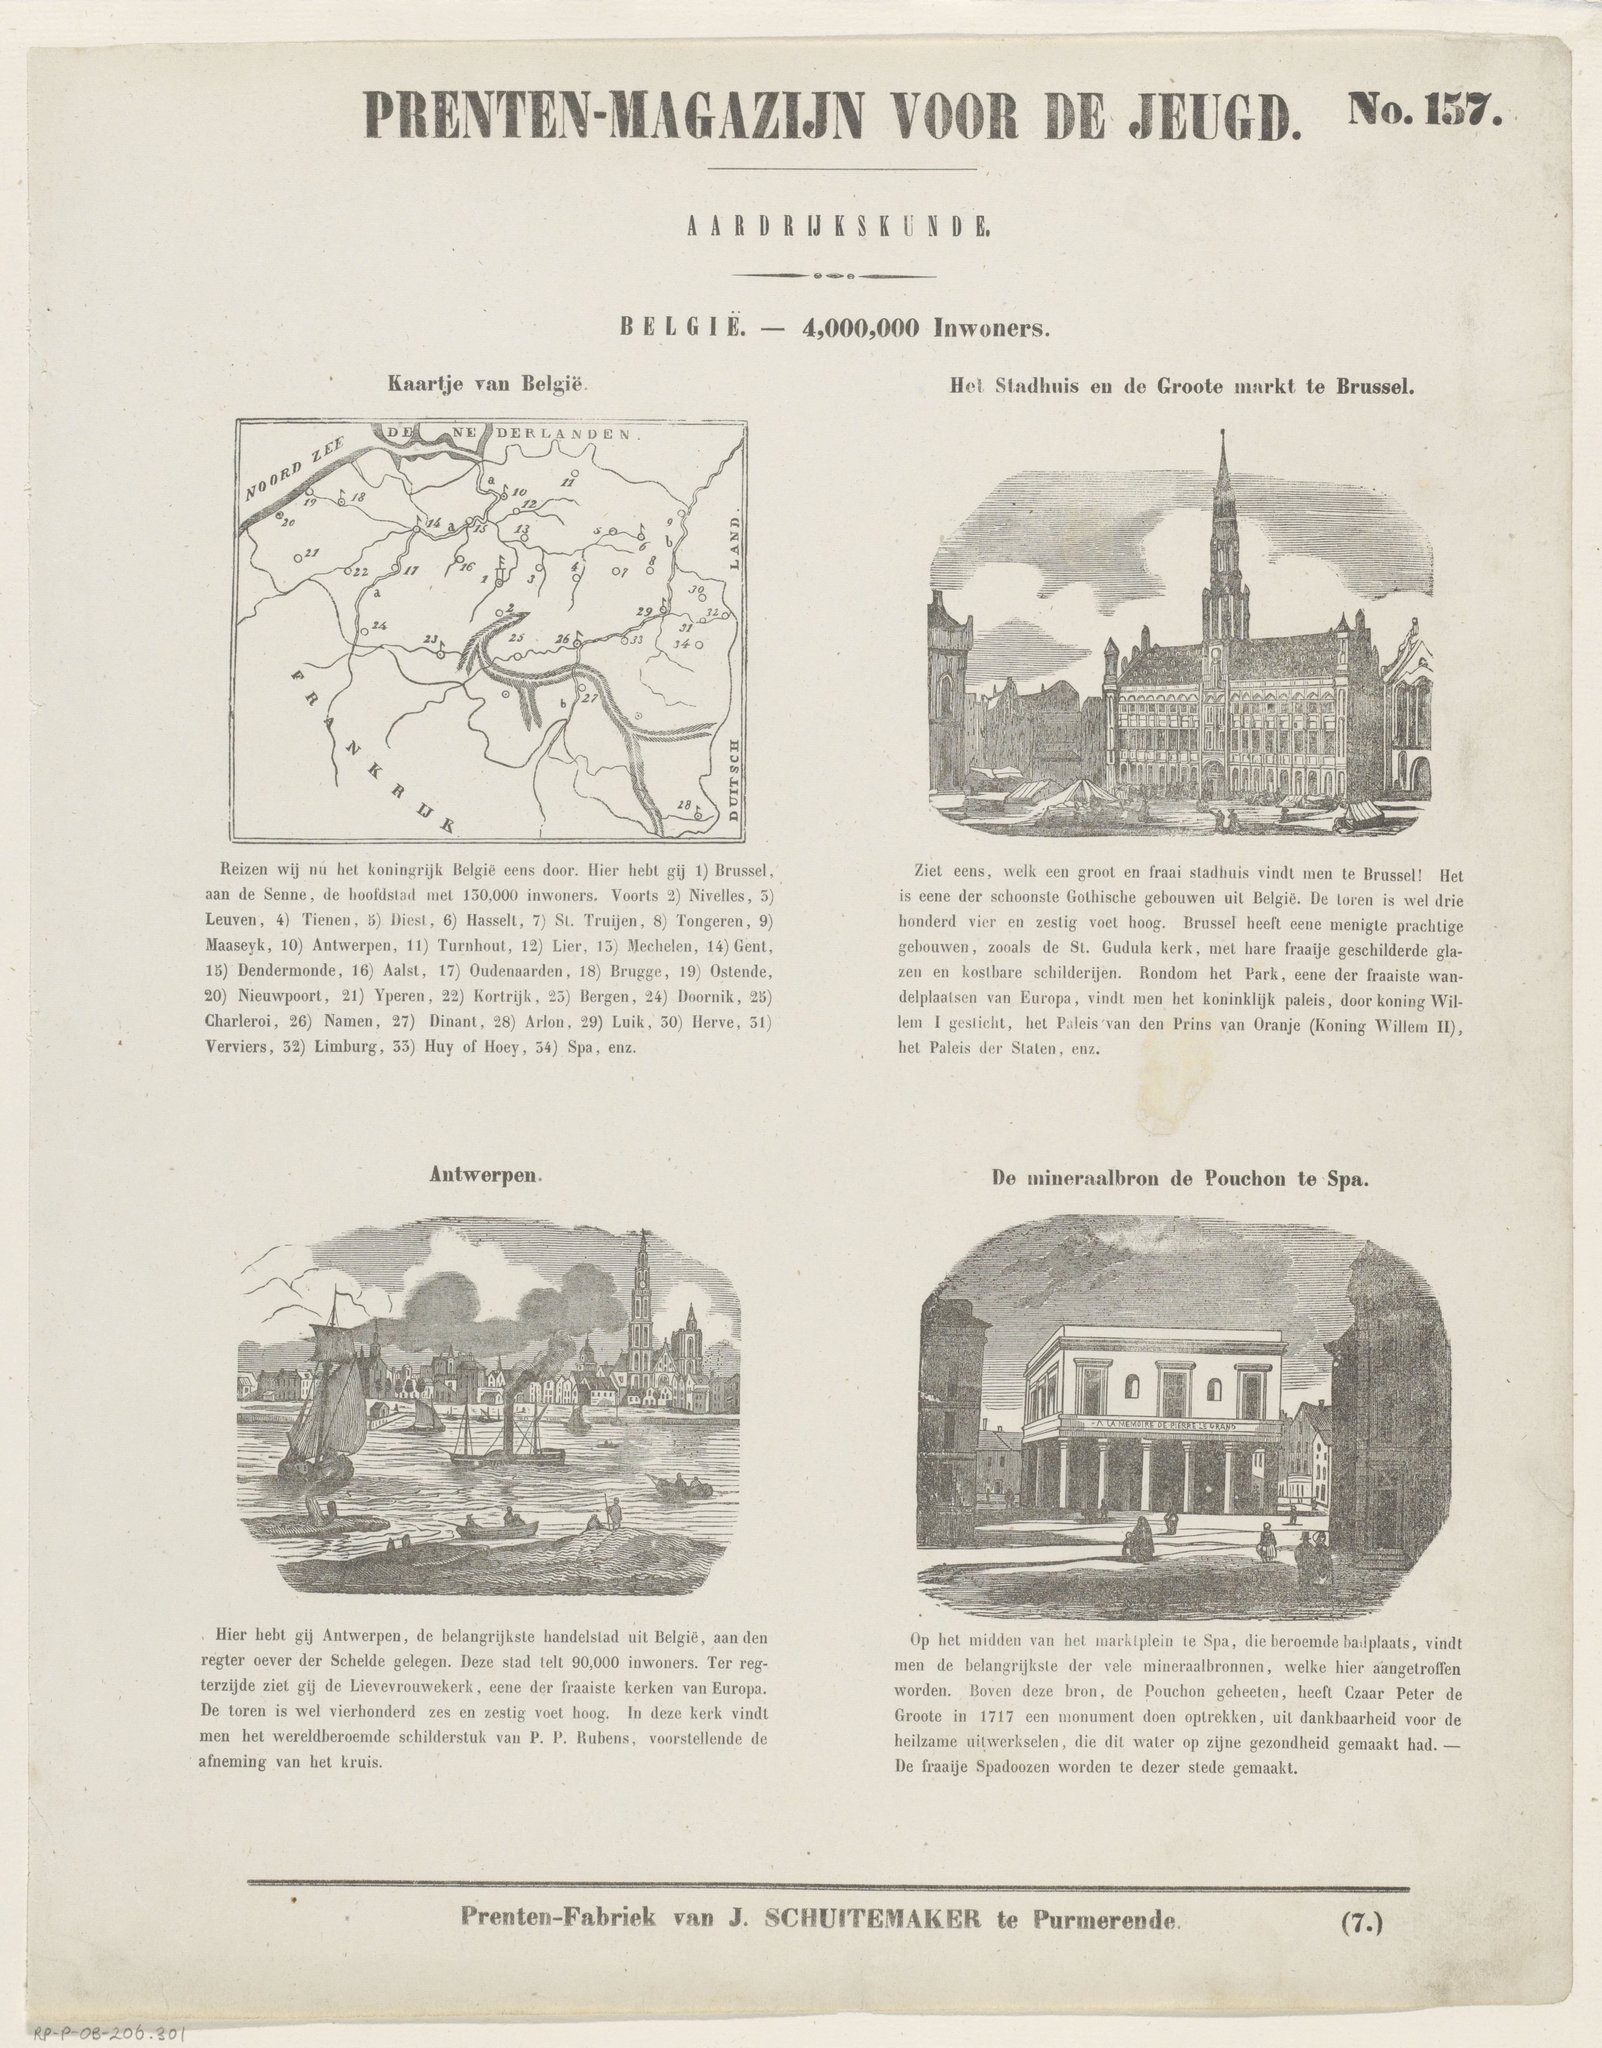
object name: popular print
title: Aardrijkskunde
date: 1850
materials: paper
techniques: letterpress printing, engraving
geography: netherlands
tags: maps, atlases, antwerp, belgium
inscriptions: collector's mark: Lugt 2760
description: Na voltooiing van de acht jaargangen van de reeks 'Prenten-magazijn voor de jeugd' in 1850 heeft Jan Schuitemaker al deze prenten heruitgegeven en omgenummerd als nr. 1 t/m 192. De oorspronkelijke jaargang wordt telkens nog vermeld rechtsonder op de prent. Binnen de jaargangen zijn prenten van hetzelfde thema in clusters van vier achter elkaar gezet.